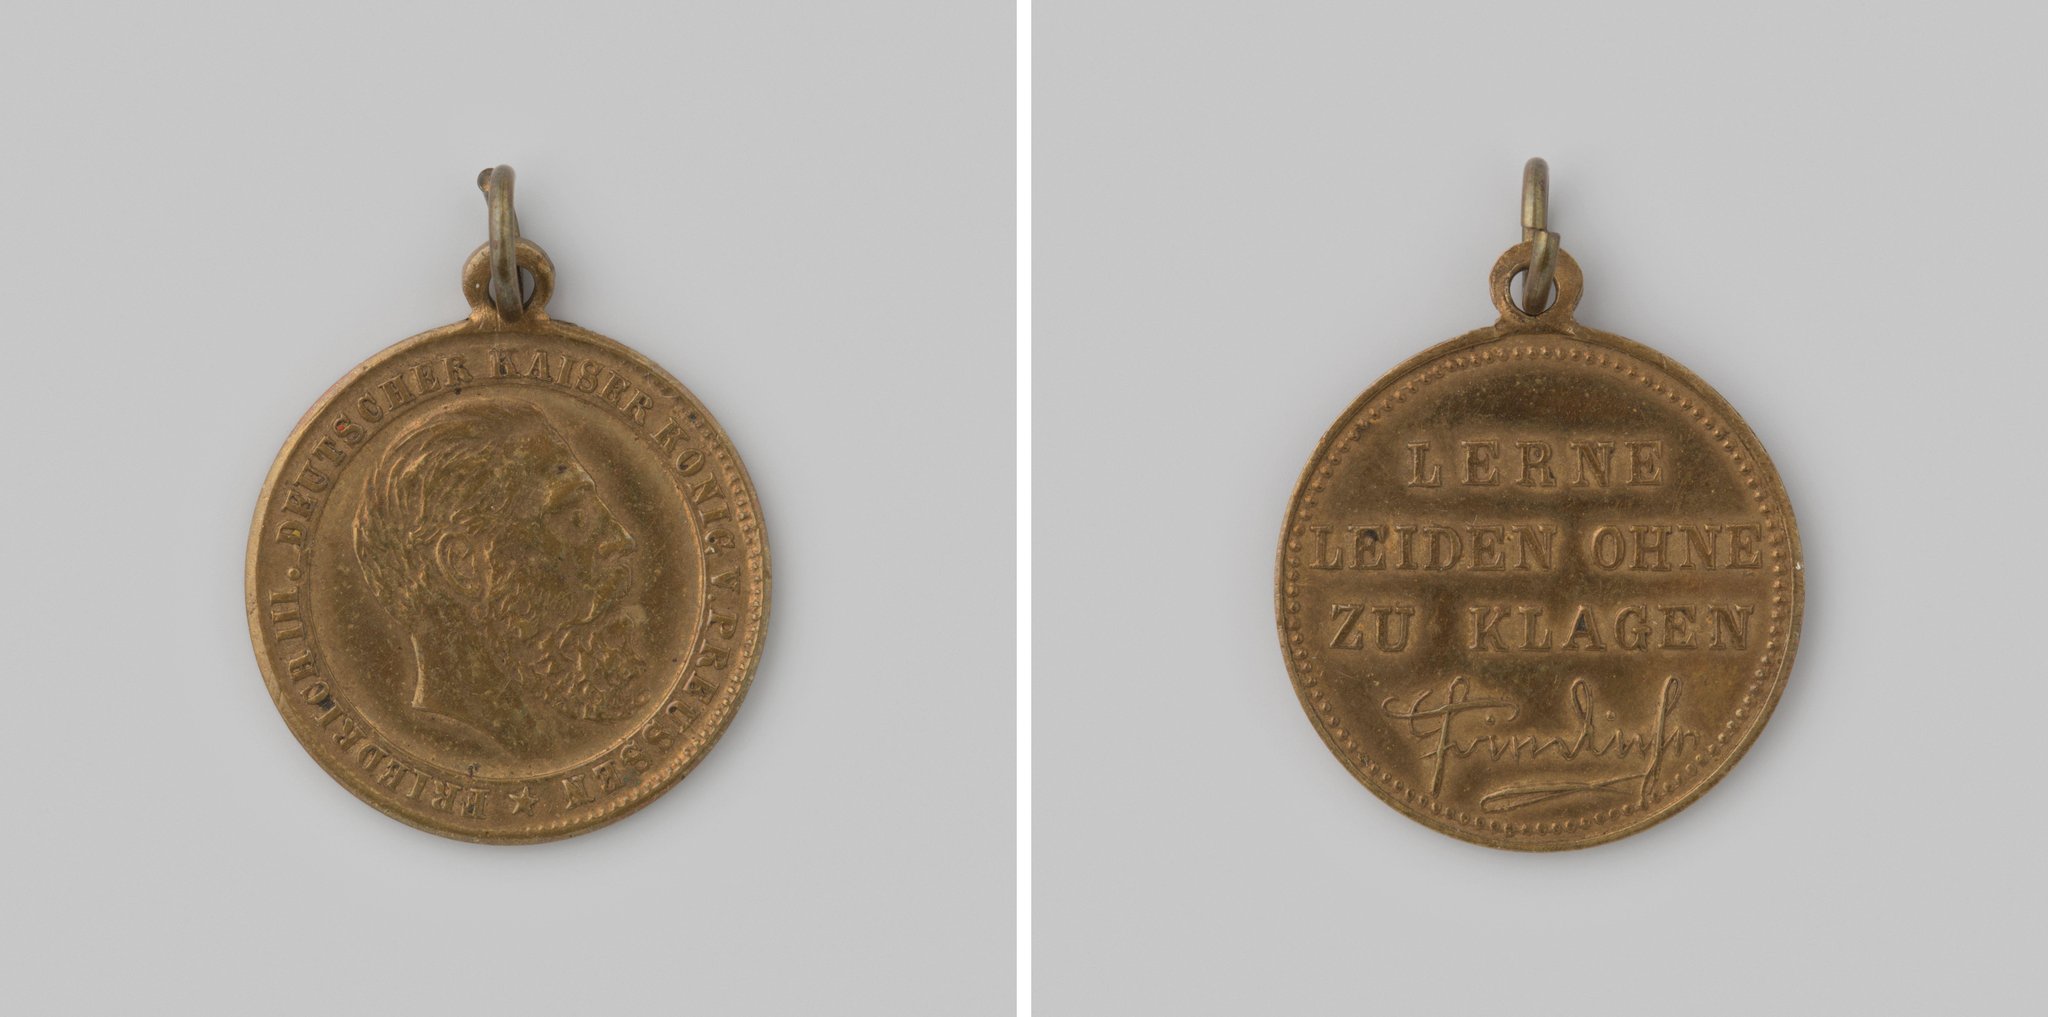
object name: history medal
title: Frederik III Keizer van Duitsland 1888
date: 1888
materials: brass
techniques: striking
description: Messing penning met oog en draagring, op de voorzijde het portret van Keizer Frederik III naar rechts met omschrift, op de keerzijde drie regels tekst en Frederiks handtekening.